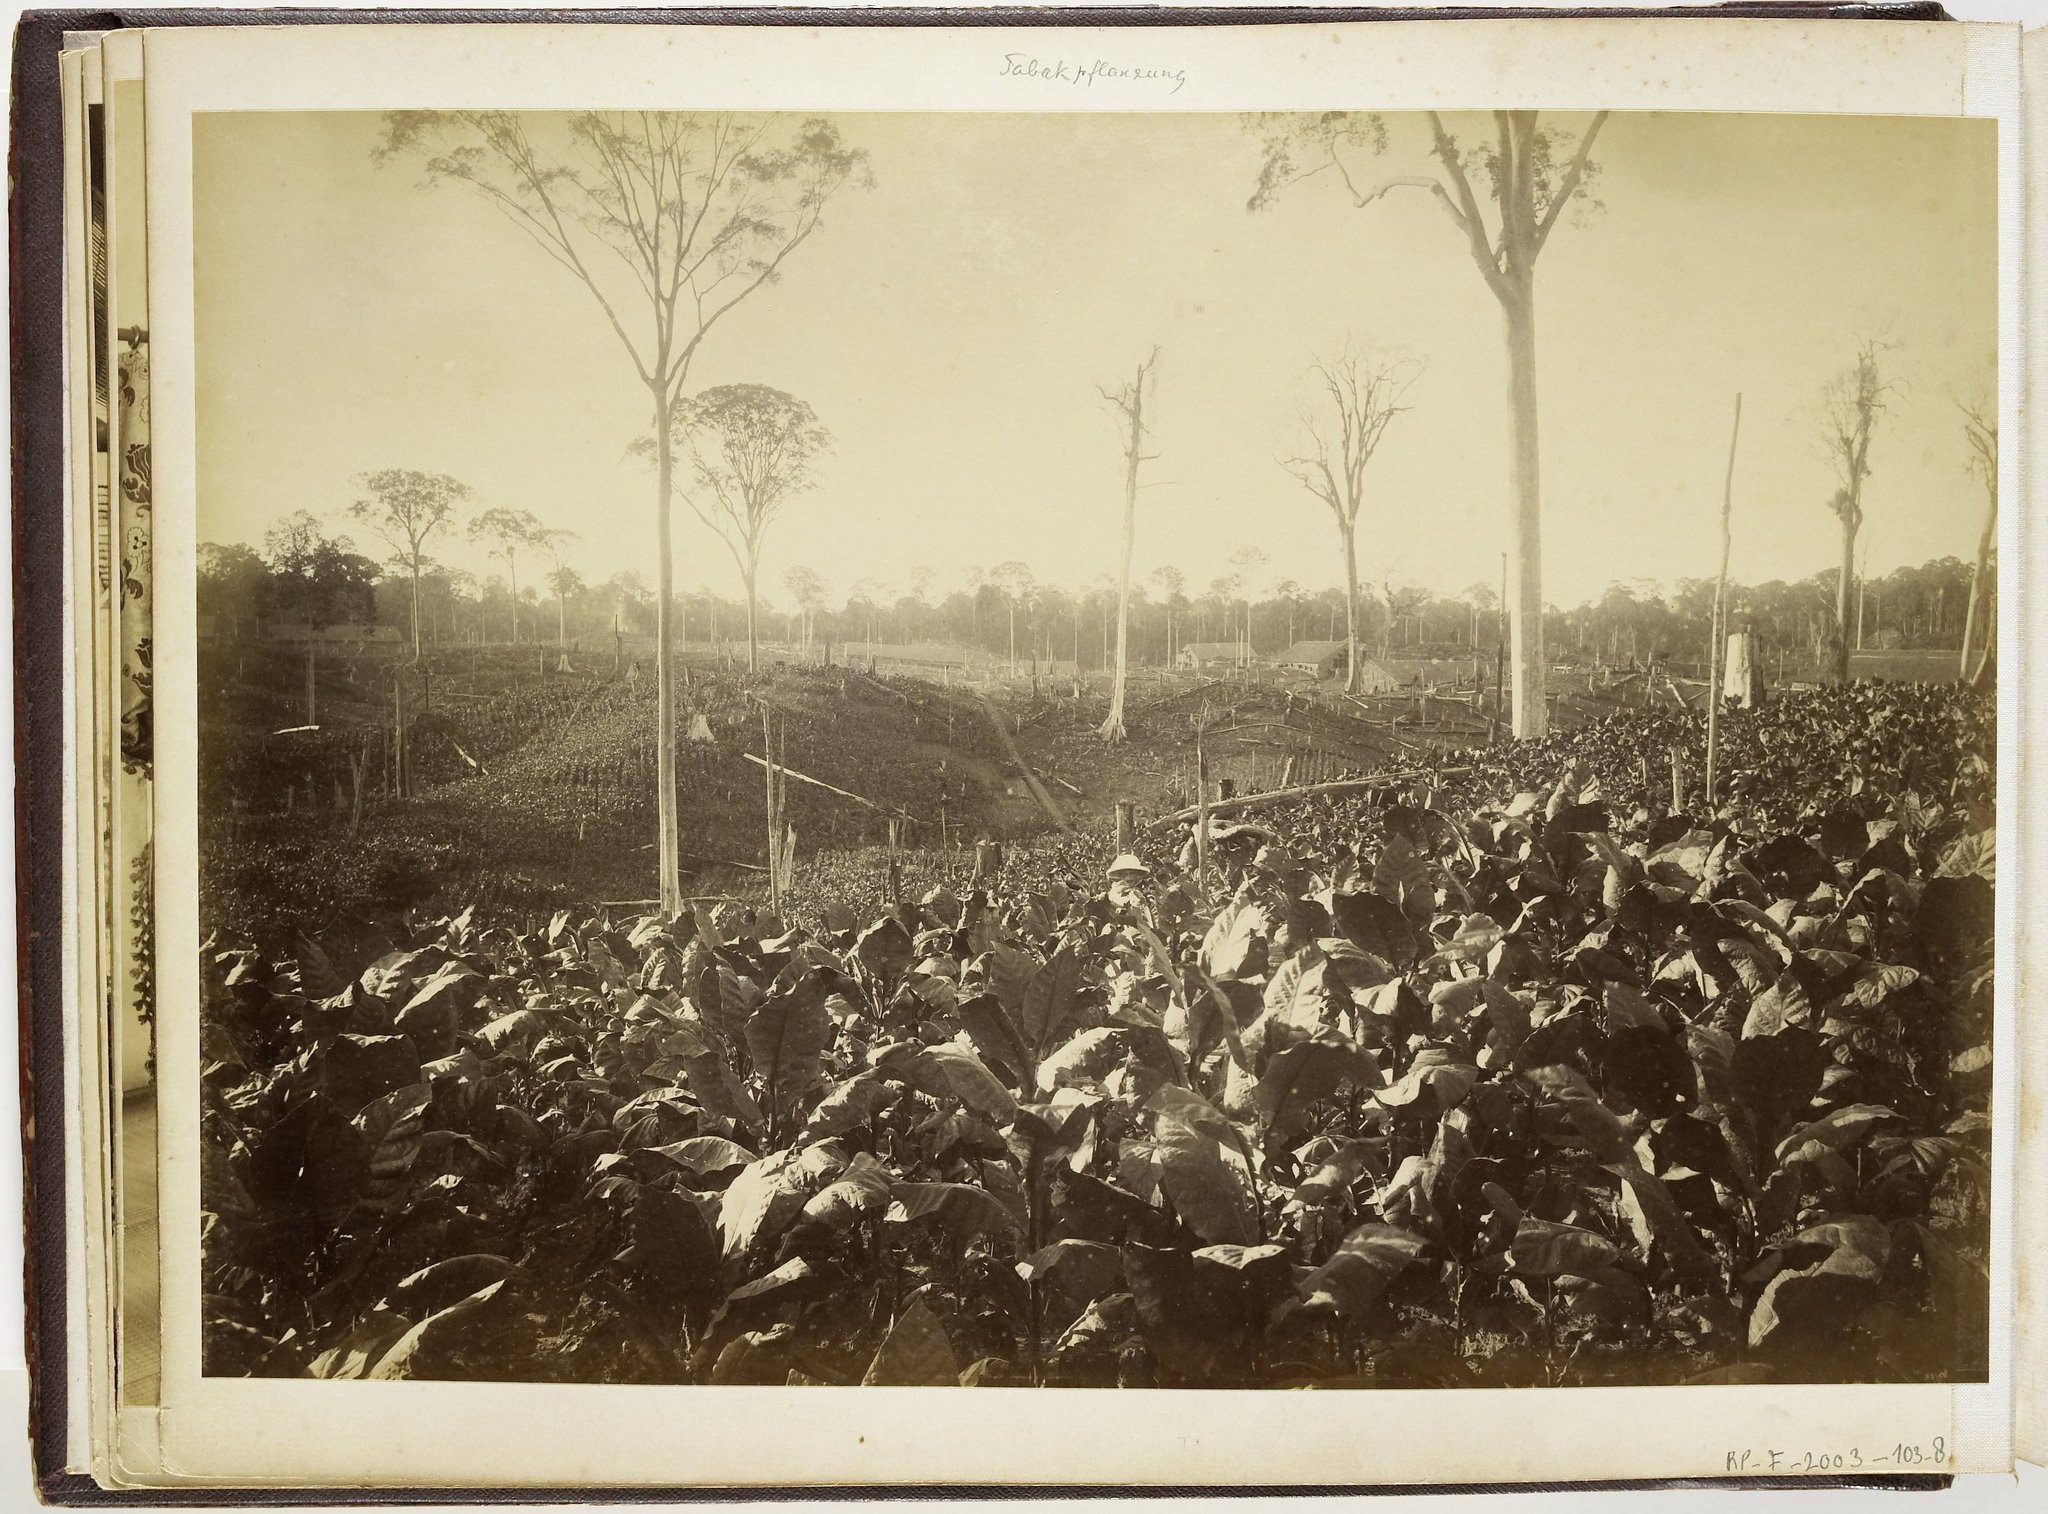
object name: photograph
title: Gezicht op de tabaksplantage Glen Bervie, Langkat Sumatra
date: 1900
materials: cardboard, paper, photographic support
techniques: albumen print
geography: bindjai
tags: tobacco, sumatra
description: vgl. tweede afdruk RP-F-2003-116 met stempel verso